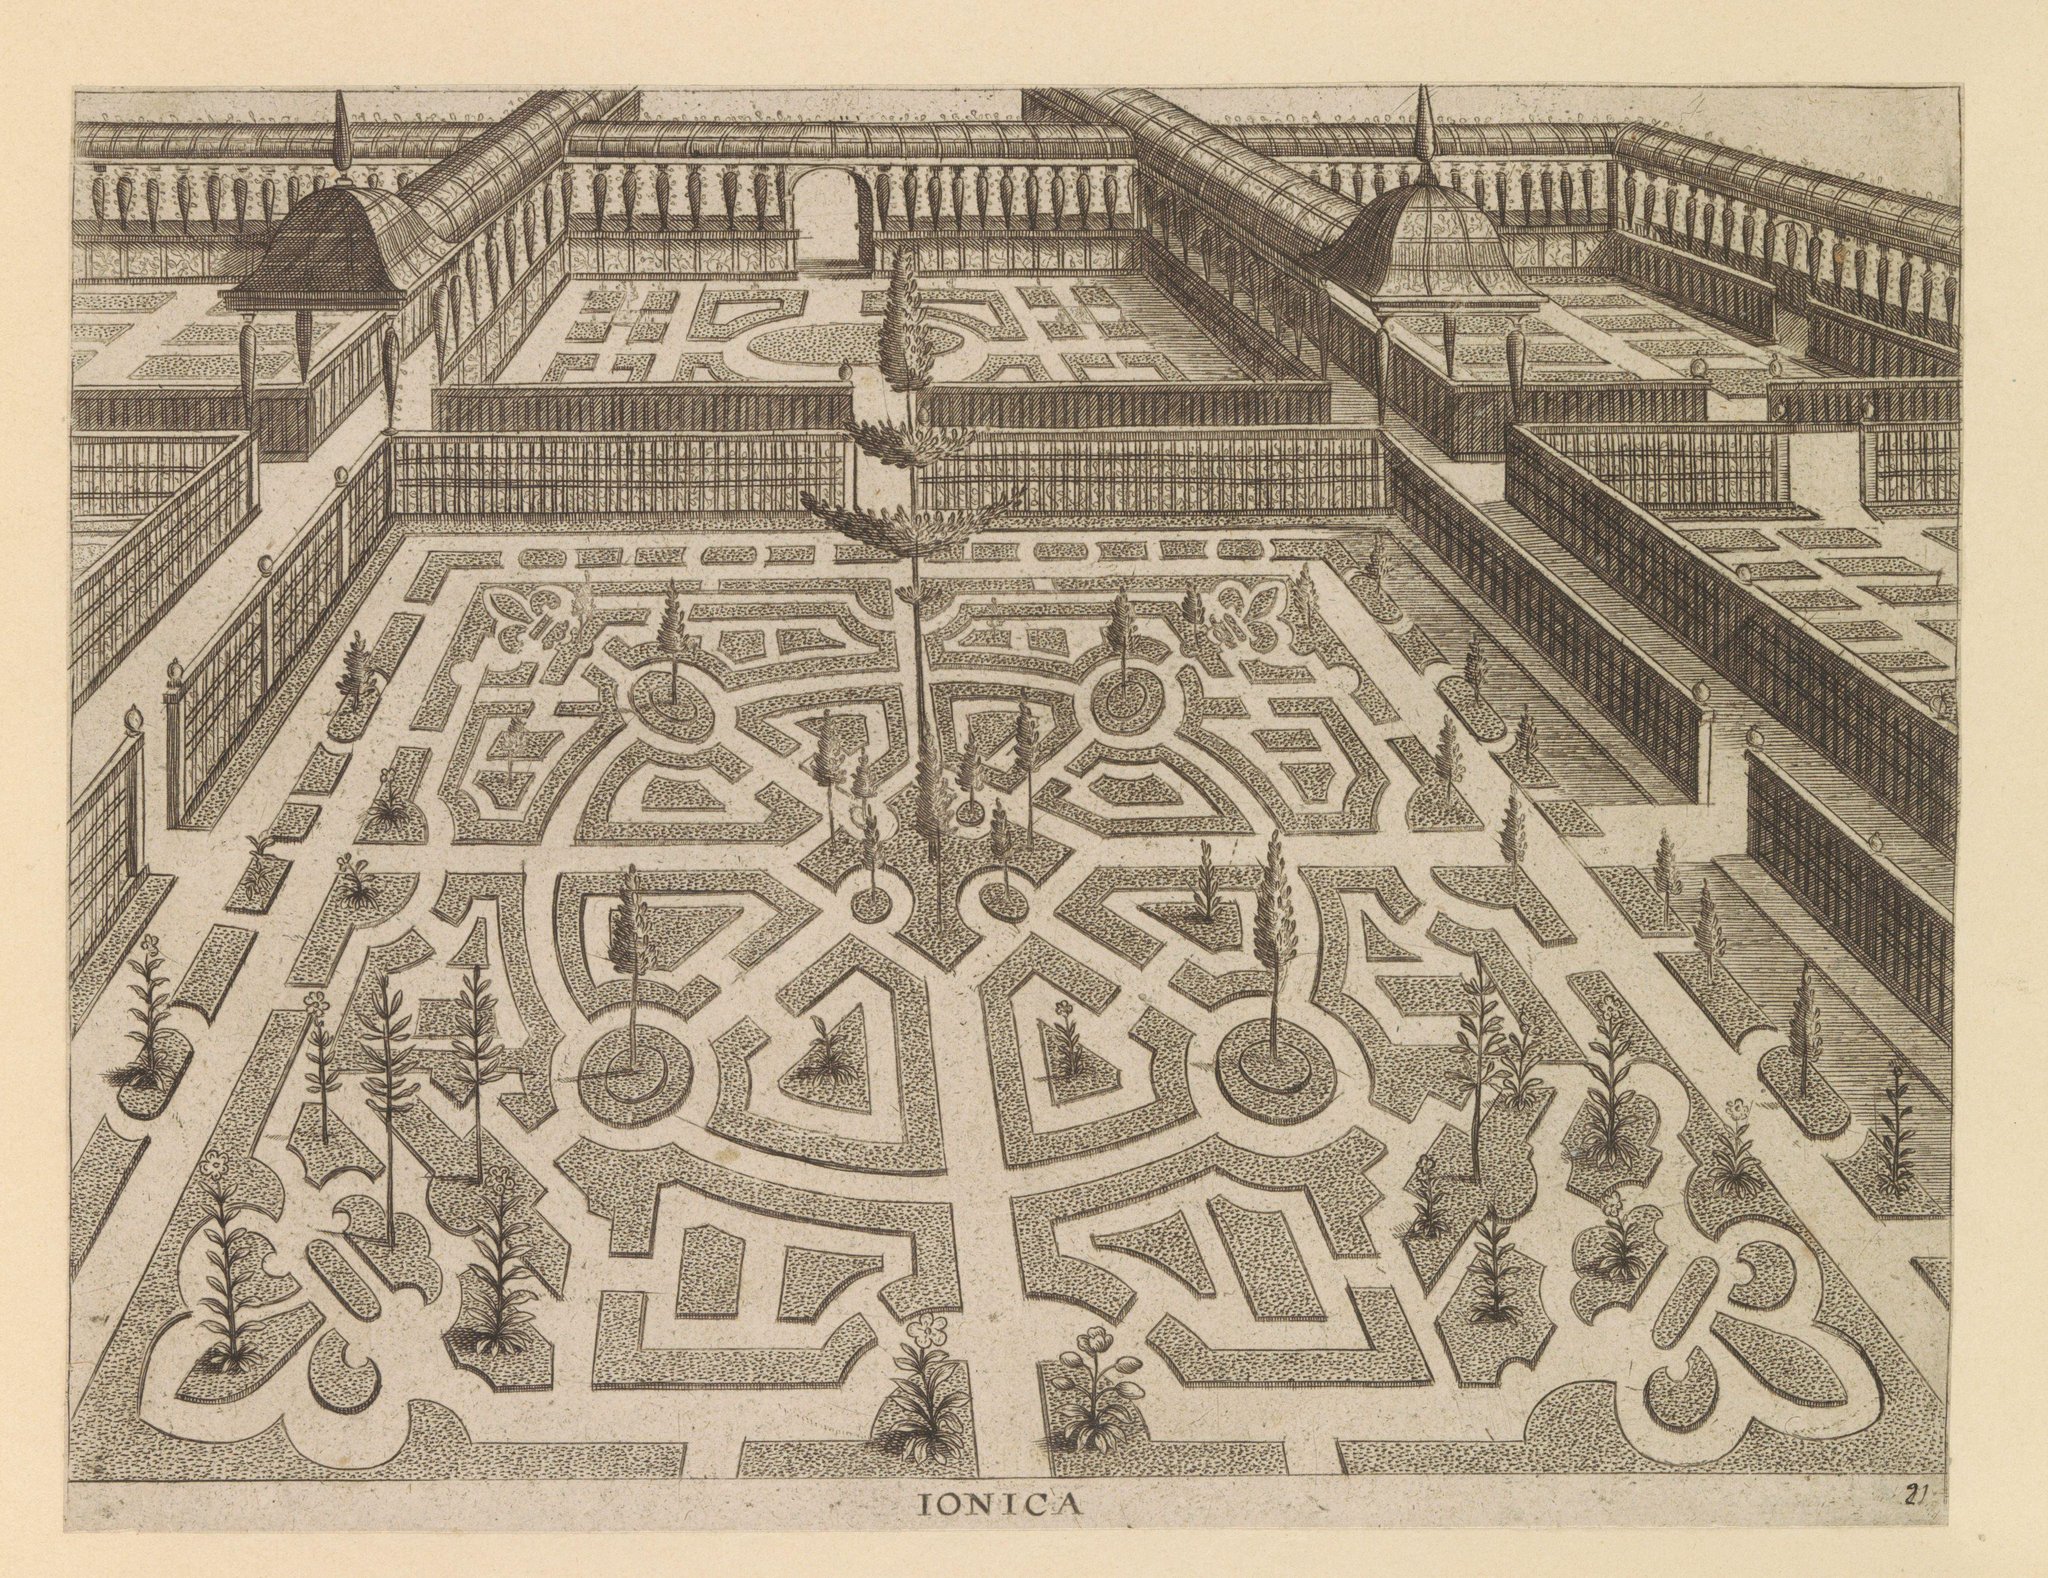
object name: album leaf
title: Tuinontwerpen geassocieerd met de Dorische, Ionische en Korinthische bouworden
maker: Anonymous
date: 1583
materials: paper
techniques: etching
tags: garden, french or architectonic garden; formal garden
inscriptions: inscription: ‘2’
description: Tuin met een parterre met in de hoeken fleurs de lis. De tuin is aangelegd volgens de Ionische bouworde. De prent maakt deel uit van een album.